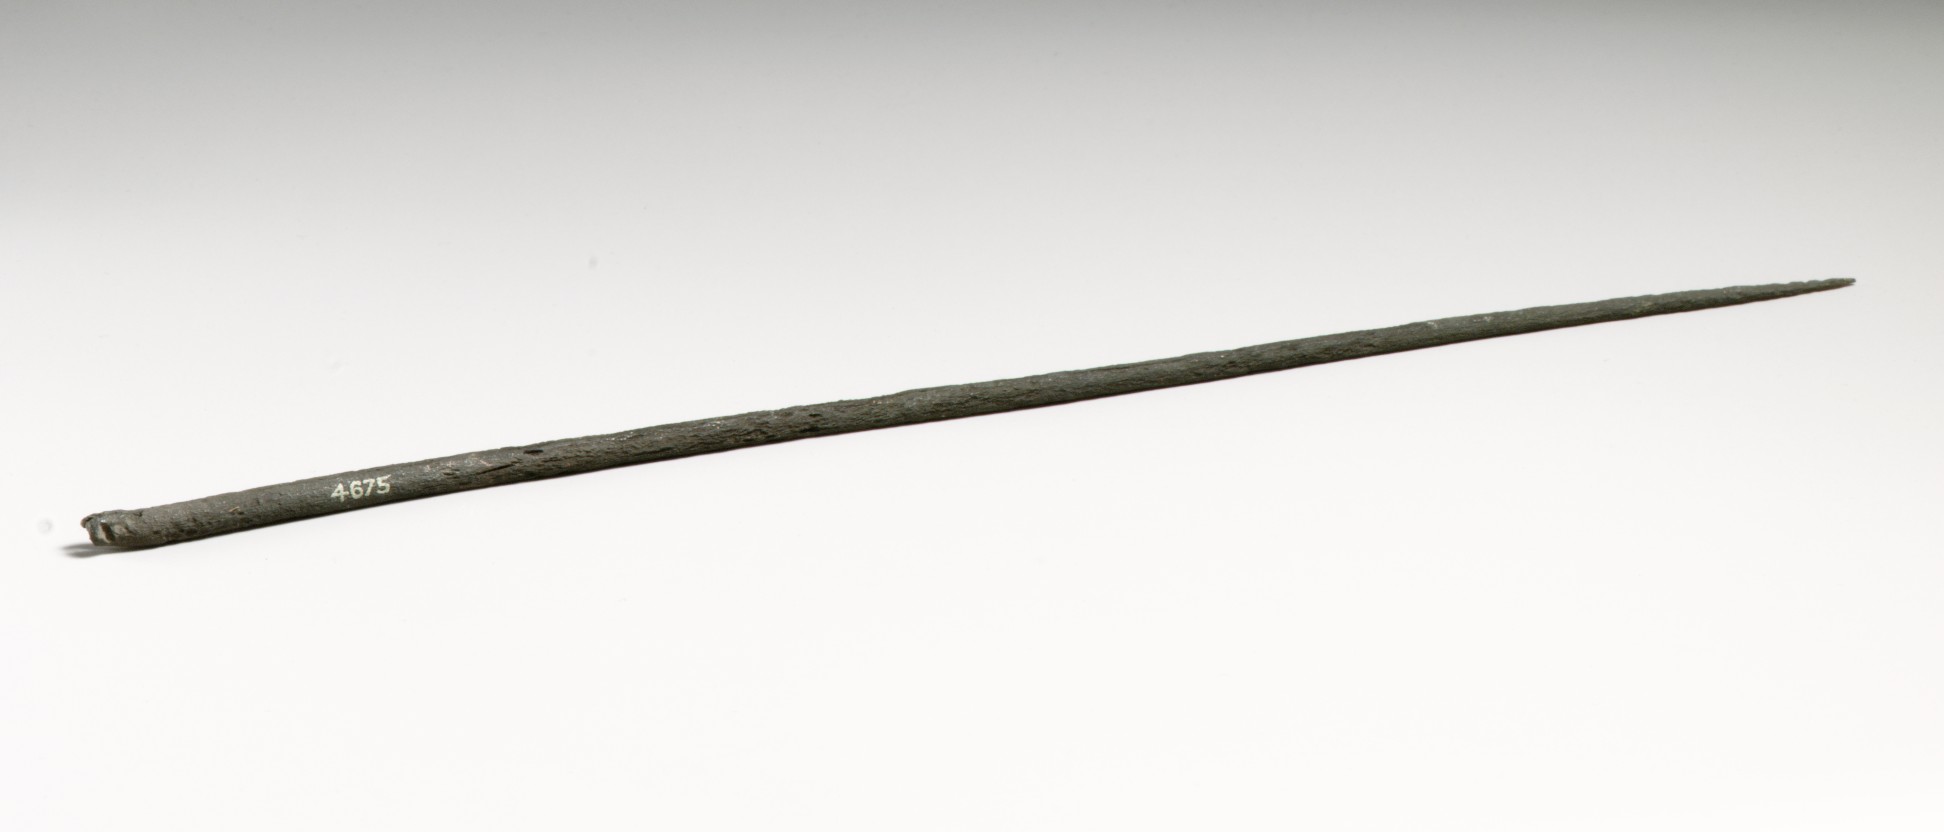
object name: pin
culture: cypriot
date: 3900 BCE-100 CE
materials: bronze